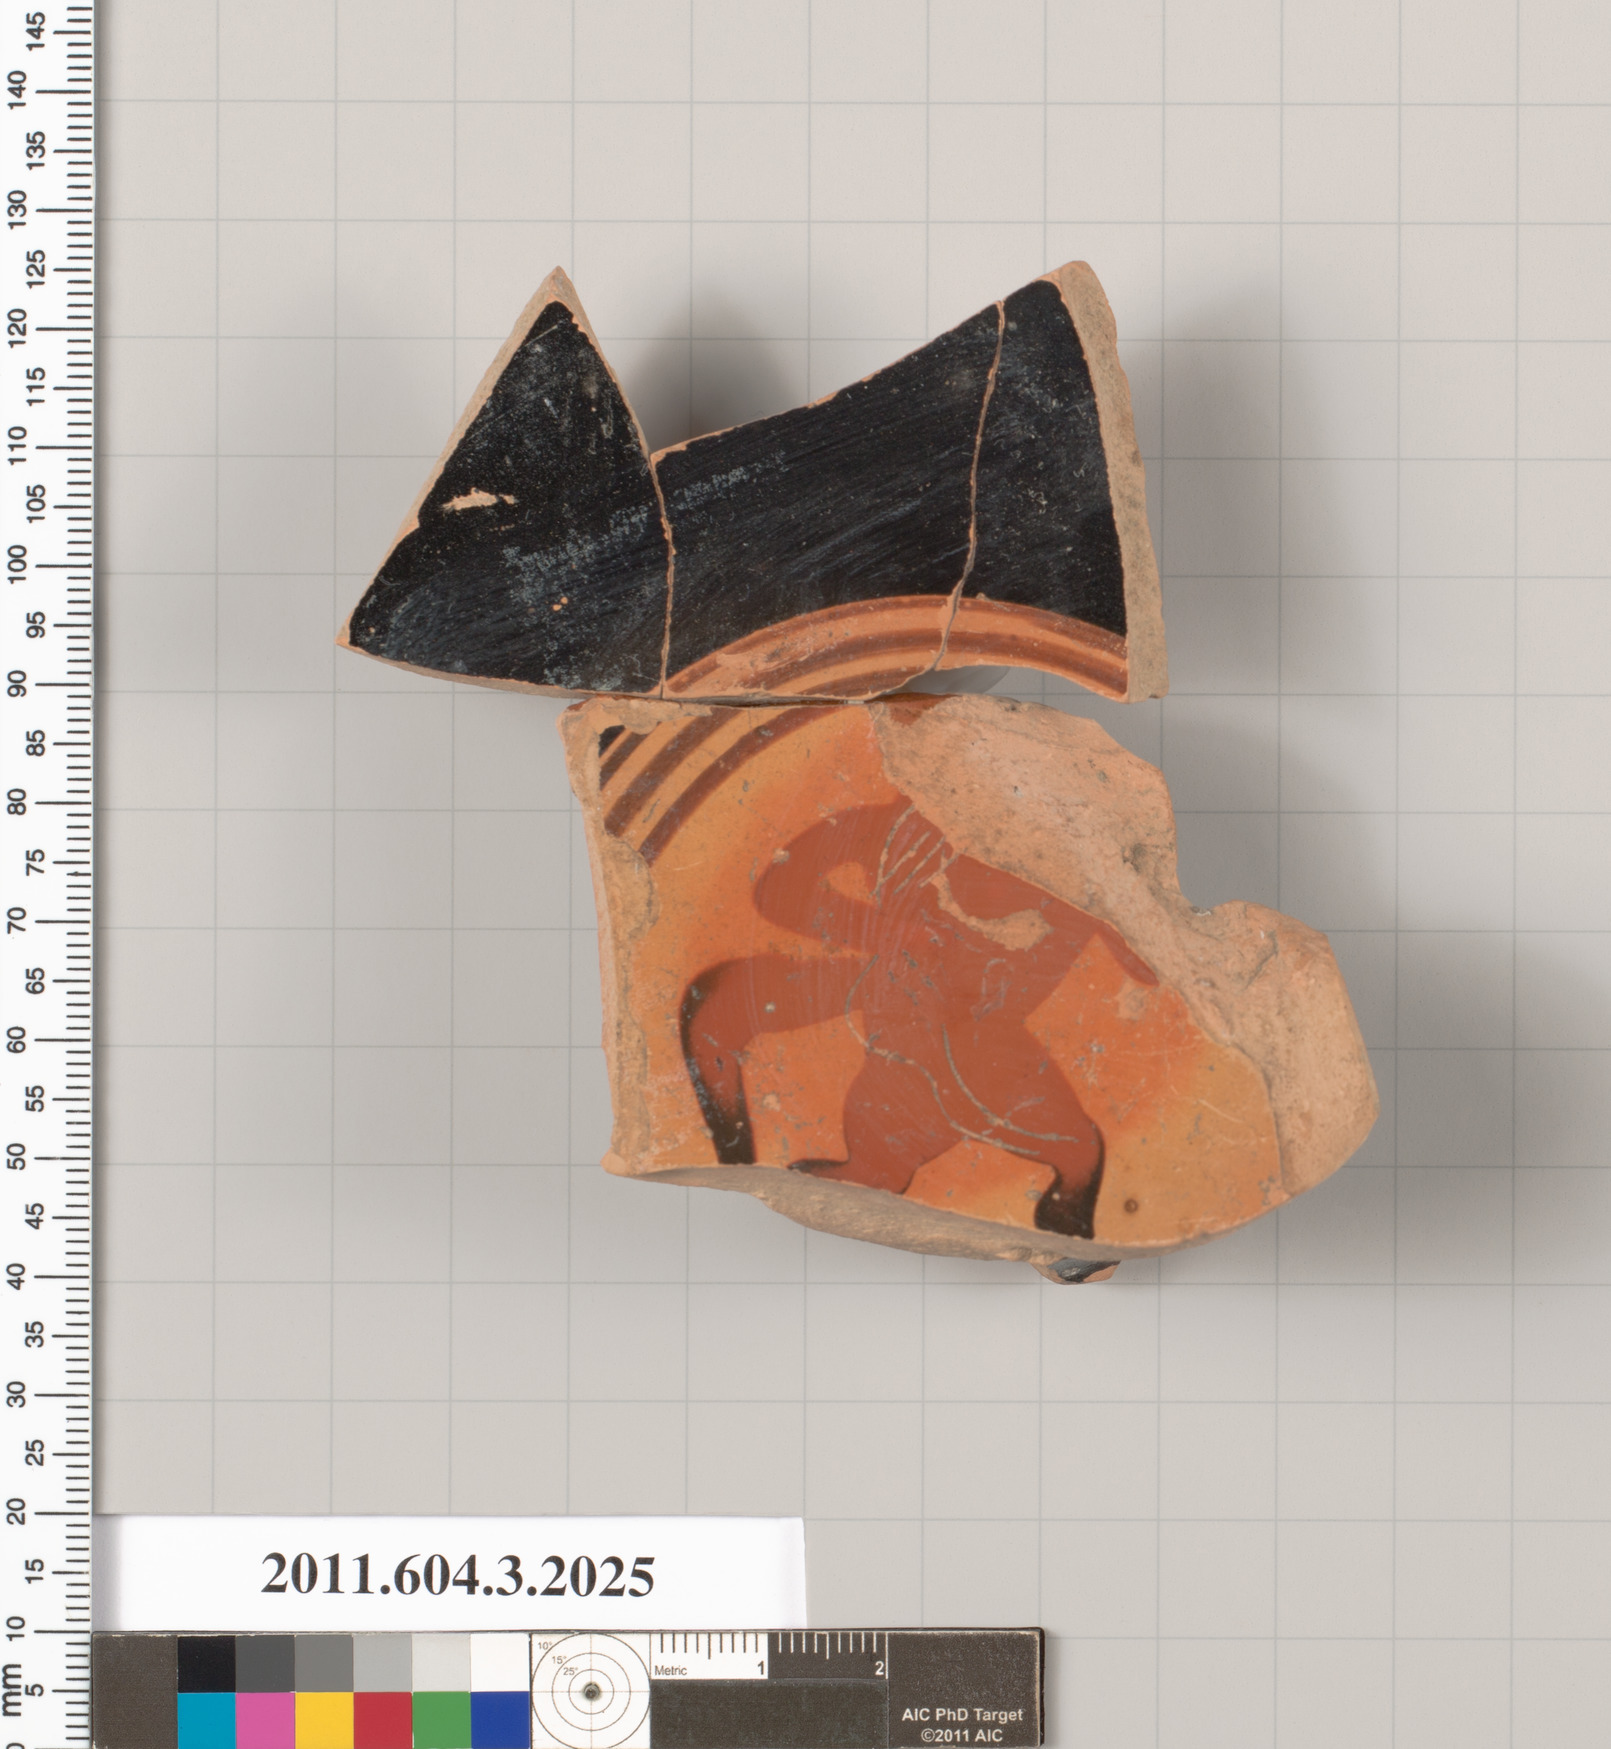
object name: kylix fragment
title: Terracotta fragment of a kylix (drinking cup)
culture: greek, attic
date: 534-468 BCE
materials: terracotta